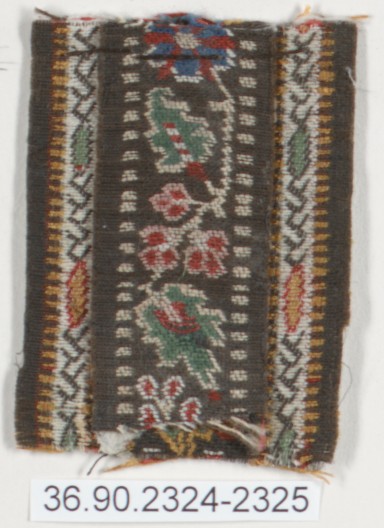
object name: border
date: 1801-1900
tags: flowers,leaves